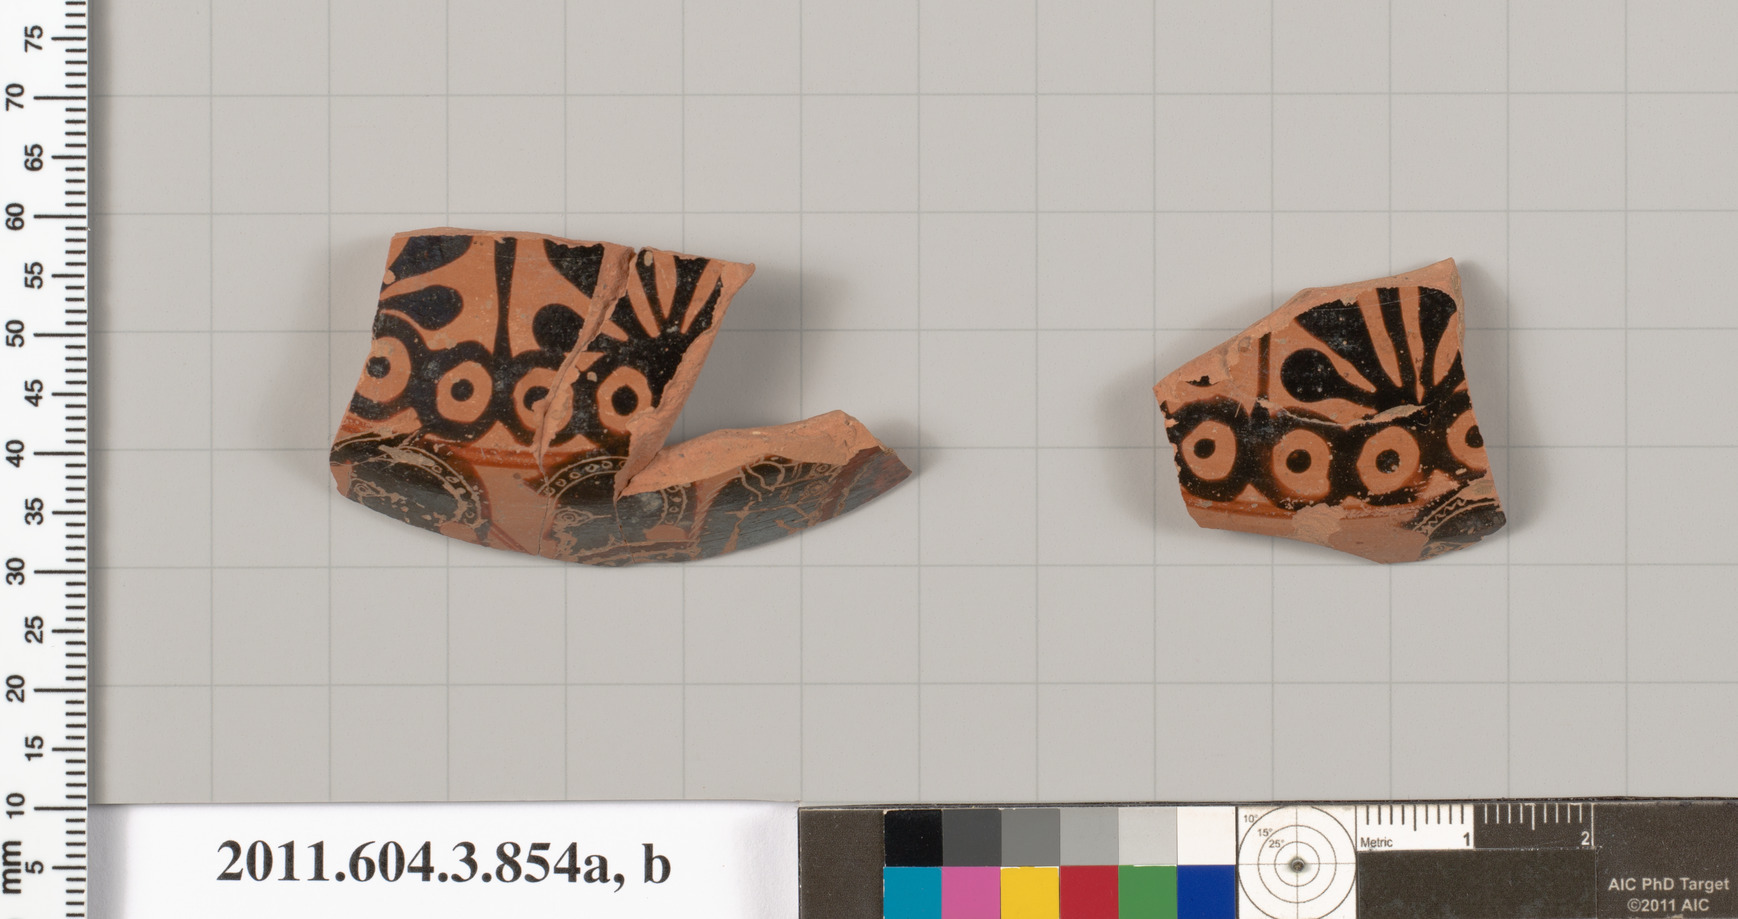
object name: lekythos fragment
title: Terracotta fragments of a lekythos (oil flask)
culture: greek, attic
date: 534-468 BCE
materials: terracotta